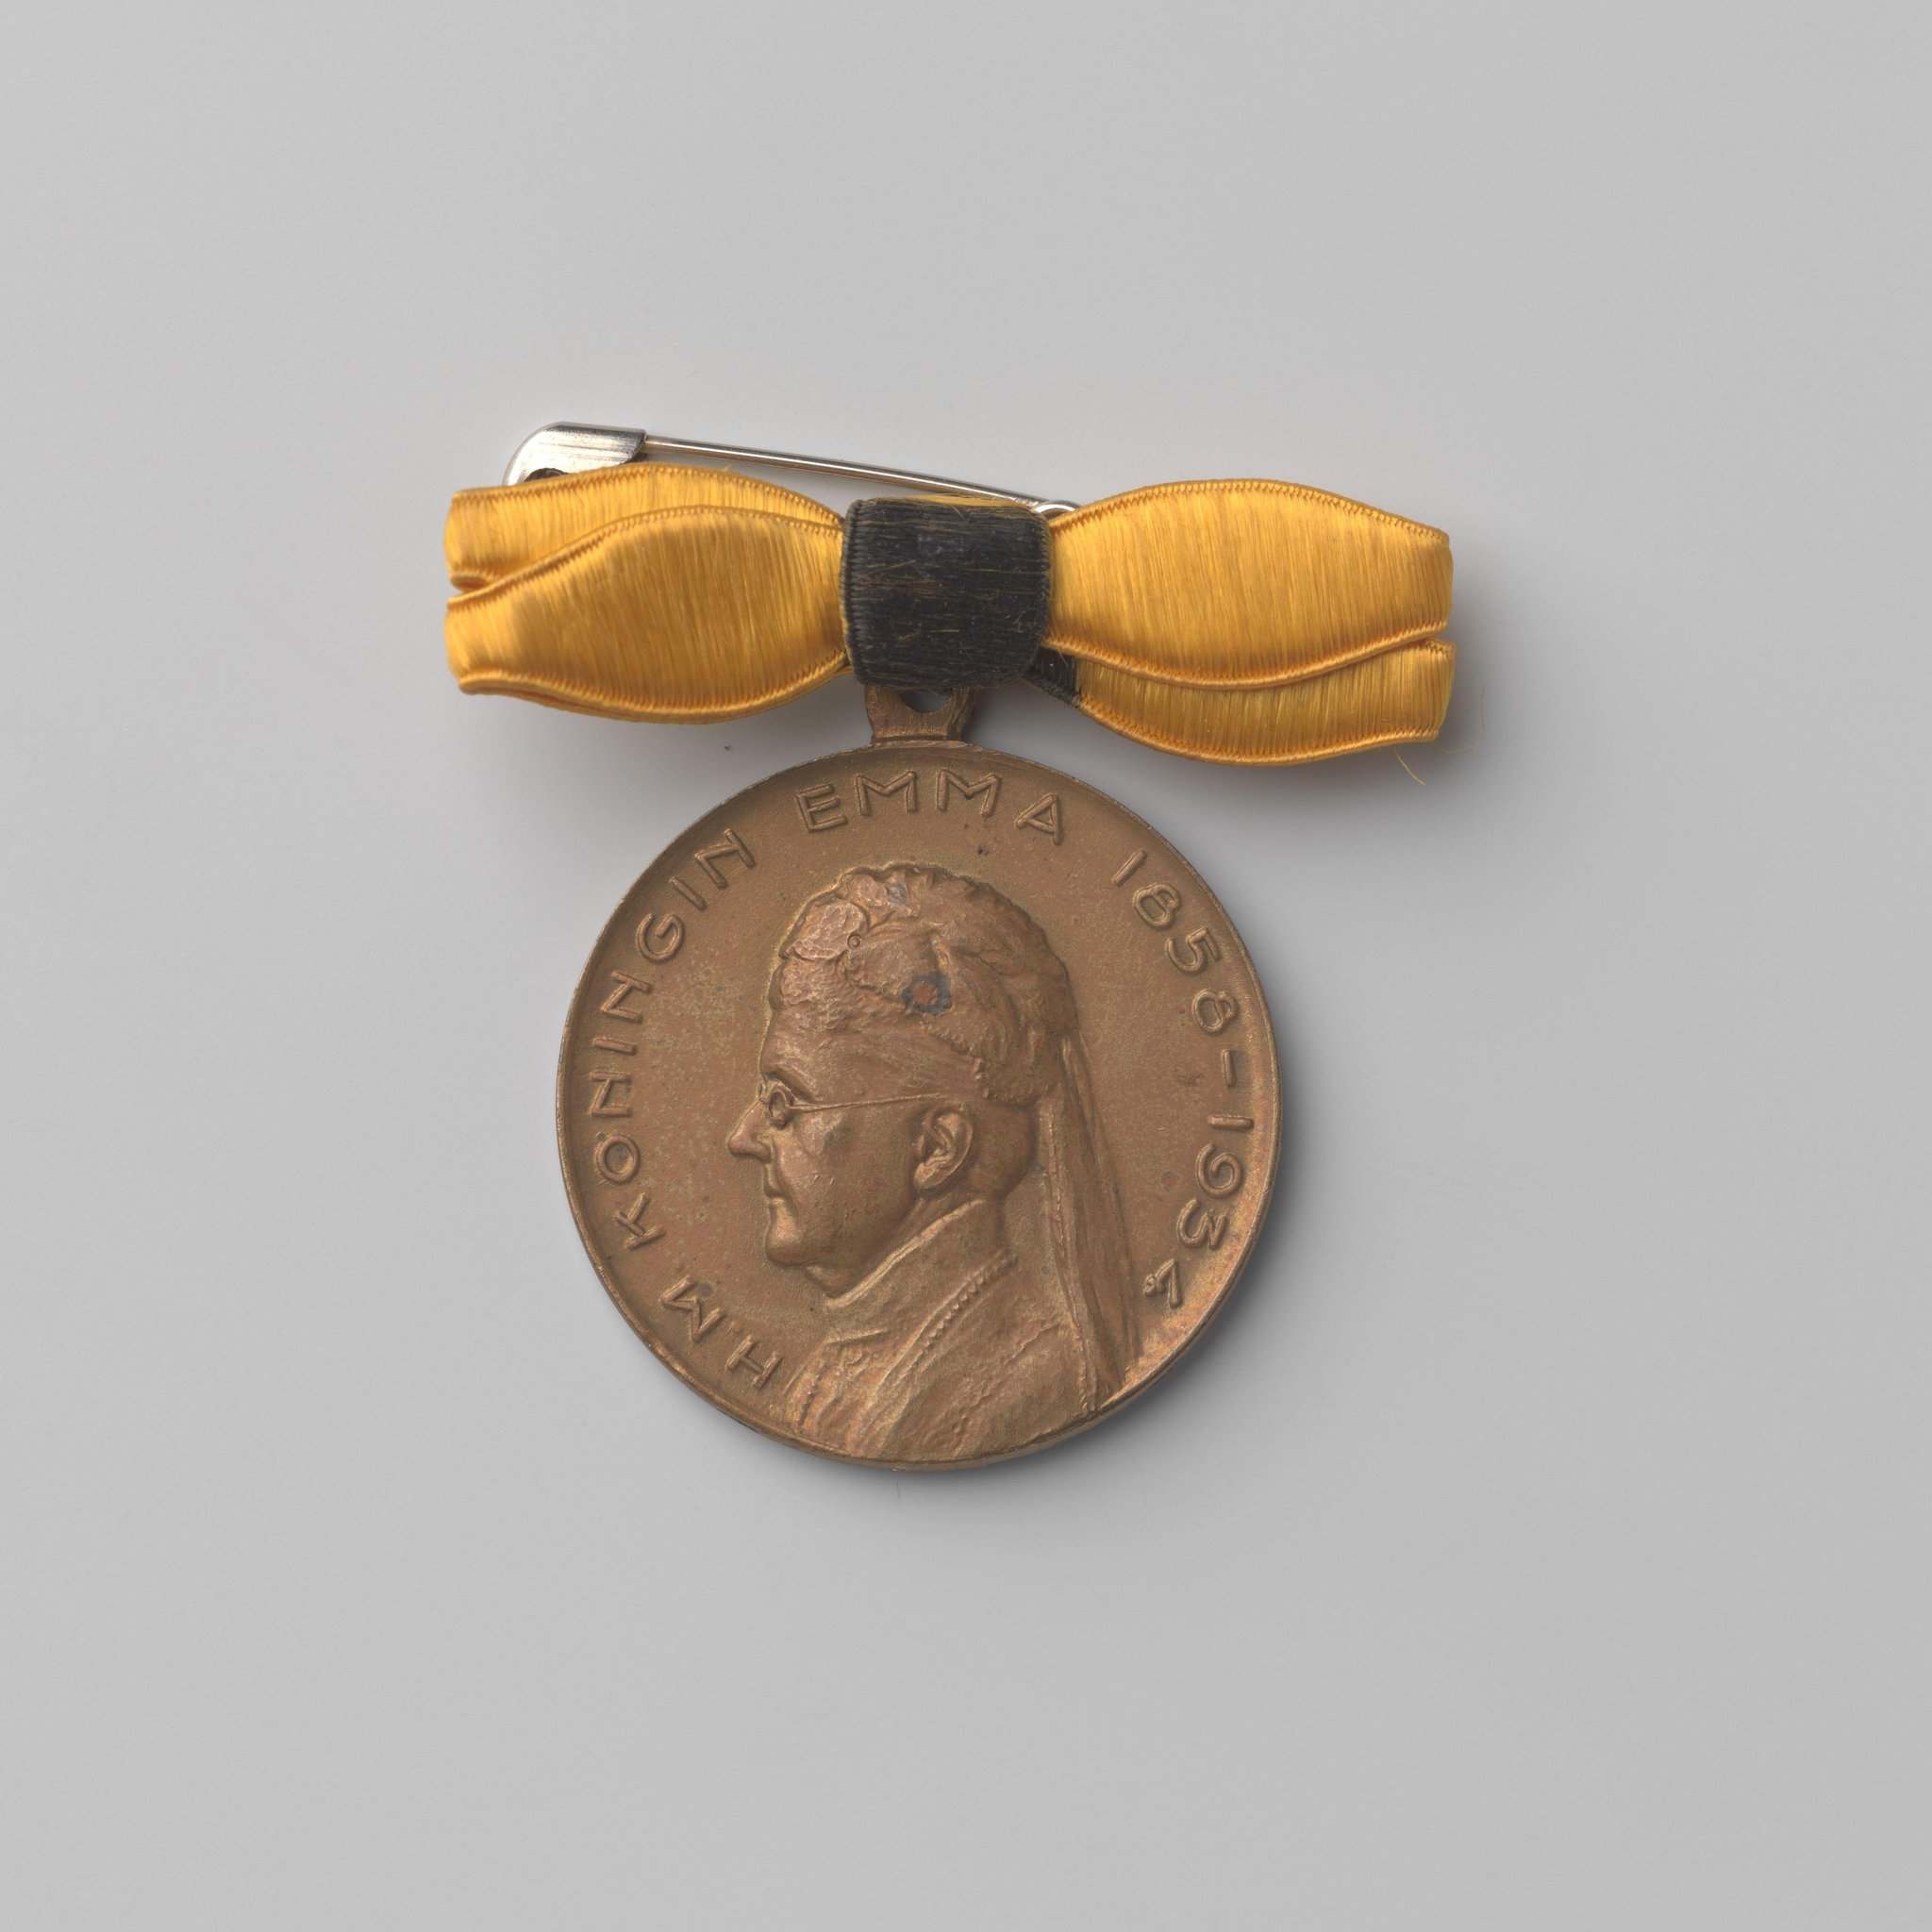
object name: history medal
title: Overlijden van Koningin Emma 1934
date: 1934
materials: bronze, textile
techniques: striking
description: Eenzijdige messing penning met draagoog aan een smalle oranje-zwarte stik met veiligheidsspeld, op de voorzijde het borstbeeld van Emma naar links met omschrift.